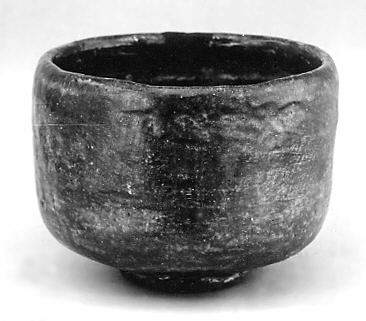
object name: teabowl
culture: japanese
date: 1801-1900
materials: pottery